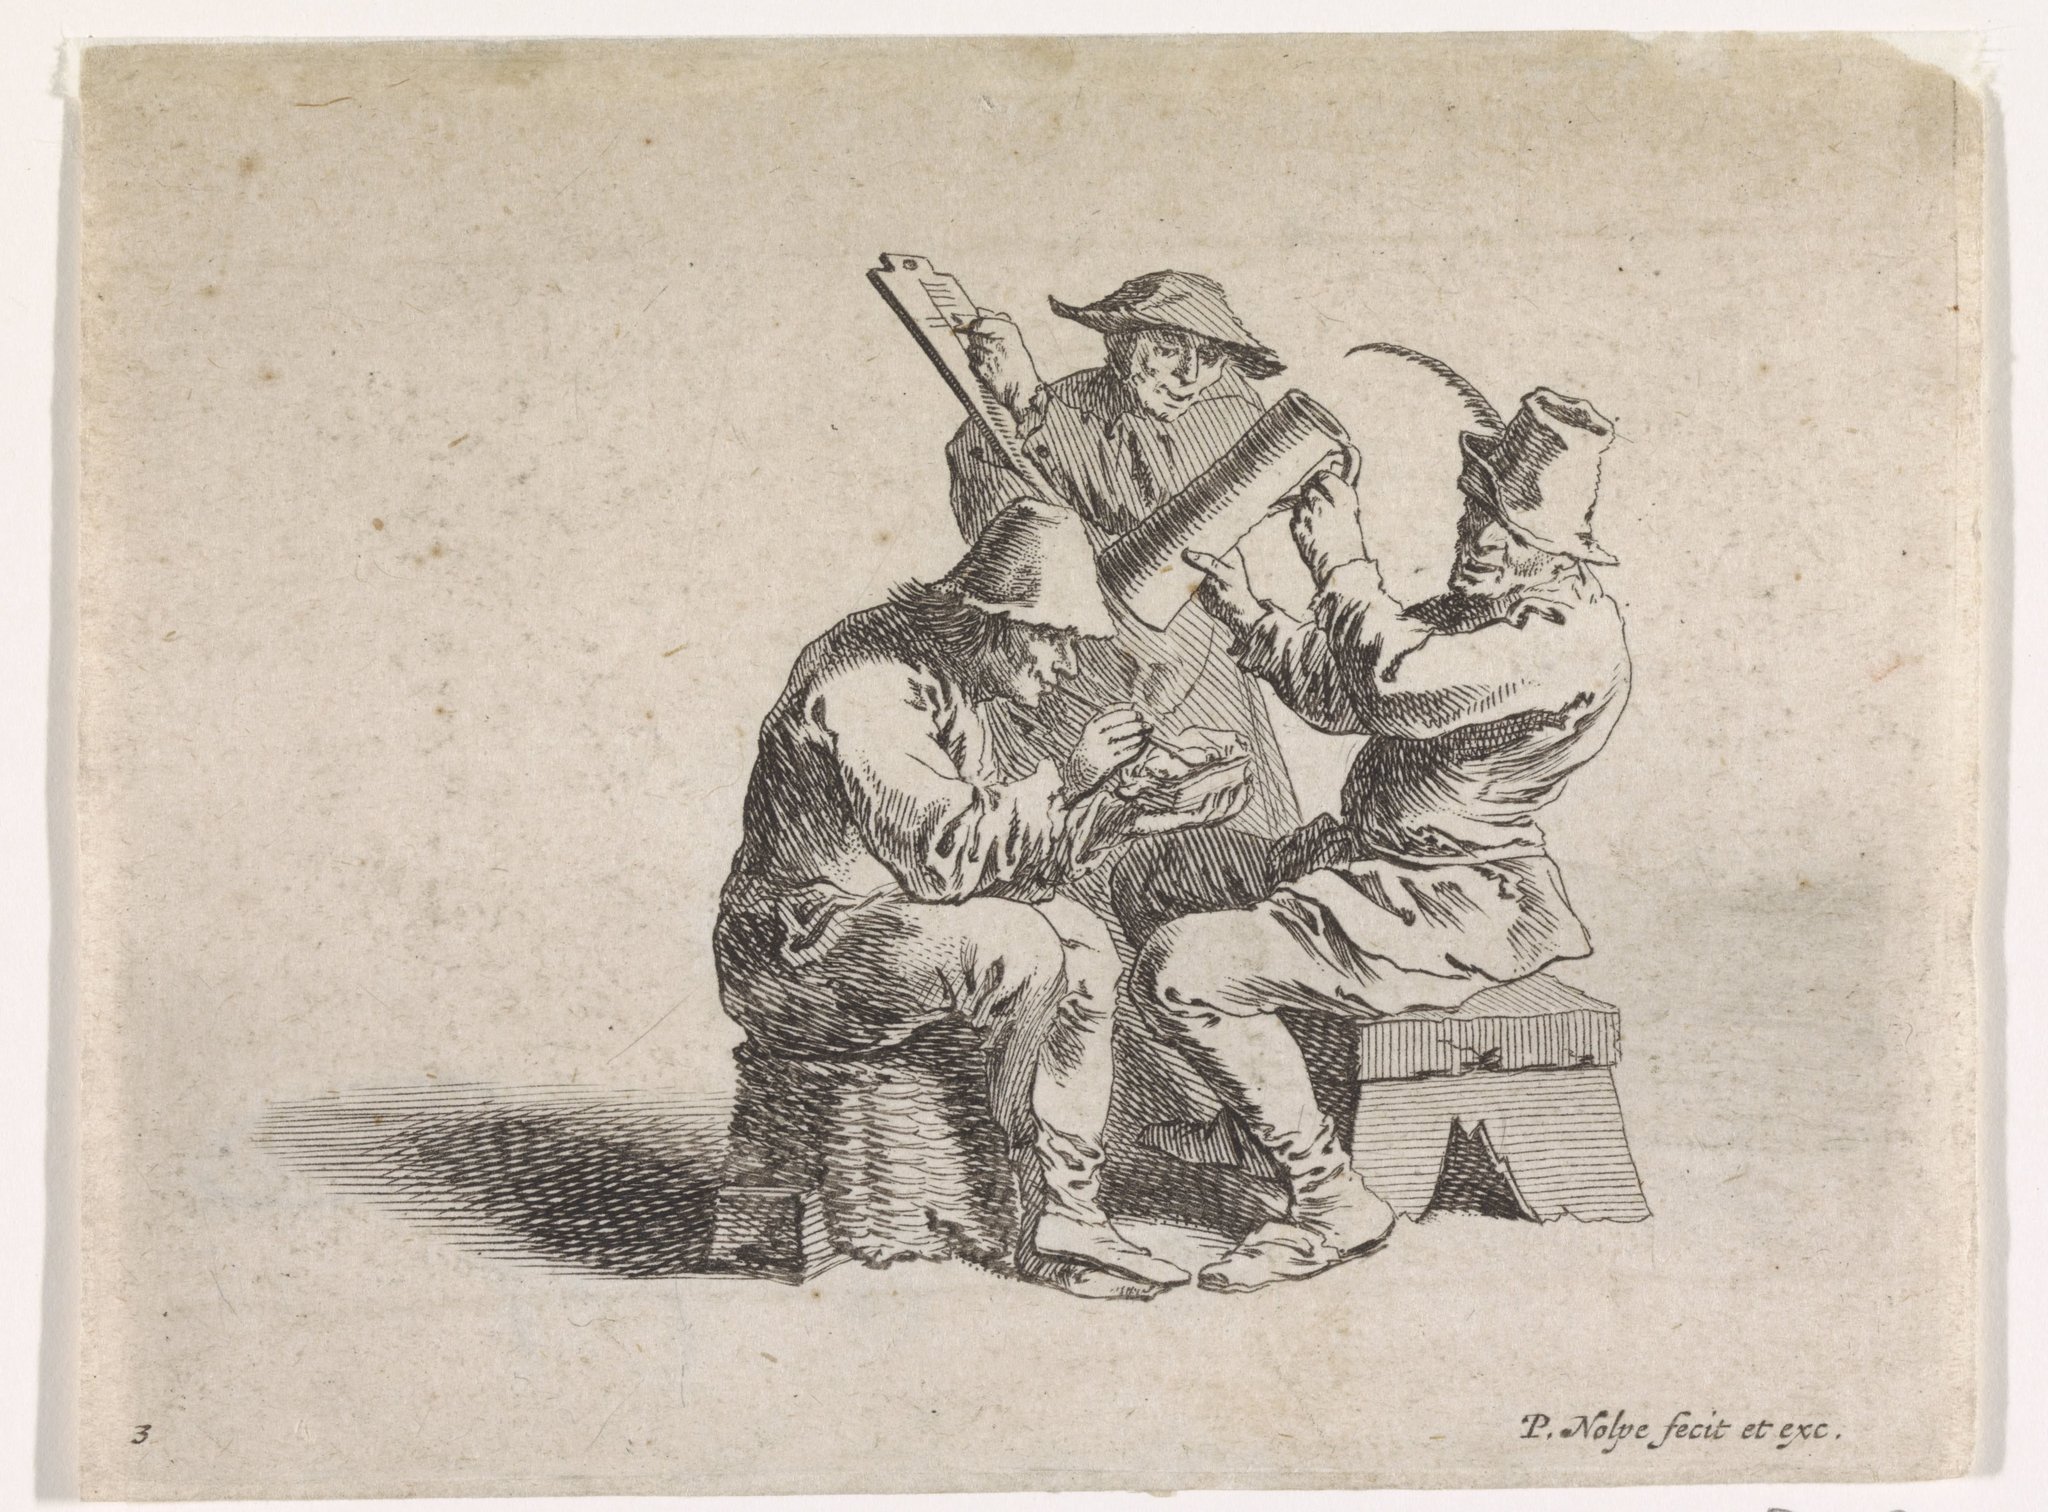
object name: print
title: Drinkende en rokende boeren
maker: pieter nolpe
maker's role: draughtsman, print maker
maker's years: 1613-1653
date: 1623-1653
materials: paper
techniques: engraving, etching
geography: amsterdam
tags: pipe ~ tobacco, farmers, alcoholic drinks, writing and letters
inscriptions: collector's mark: Lugt 2228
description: Een boerin en een boer dansen naast elkaar in het gras. De boerin rookt een pijpje en heeft een sleutelbos en een mes aan haar kleed hangen. De boer houdt een drinkbeker in de ene en een viool in de andere hand. Prent maakt deel uit van een serie met scènes uit het boerenleven.